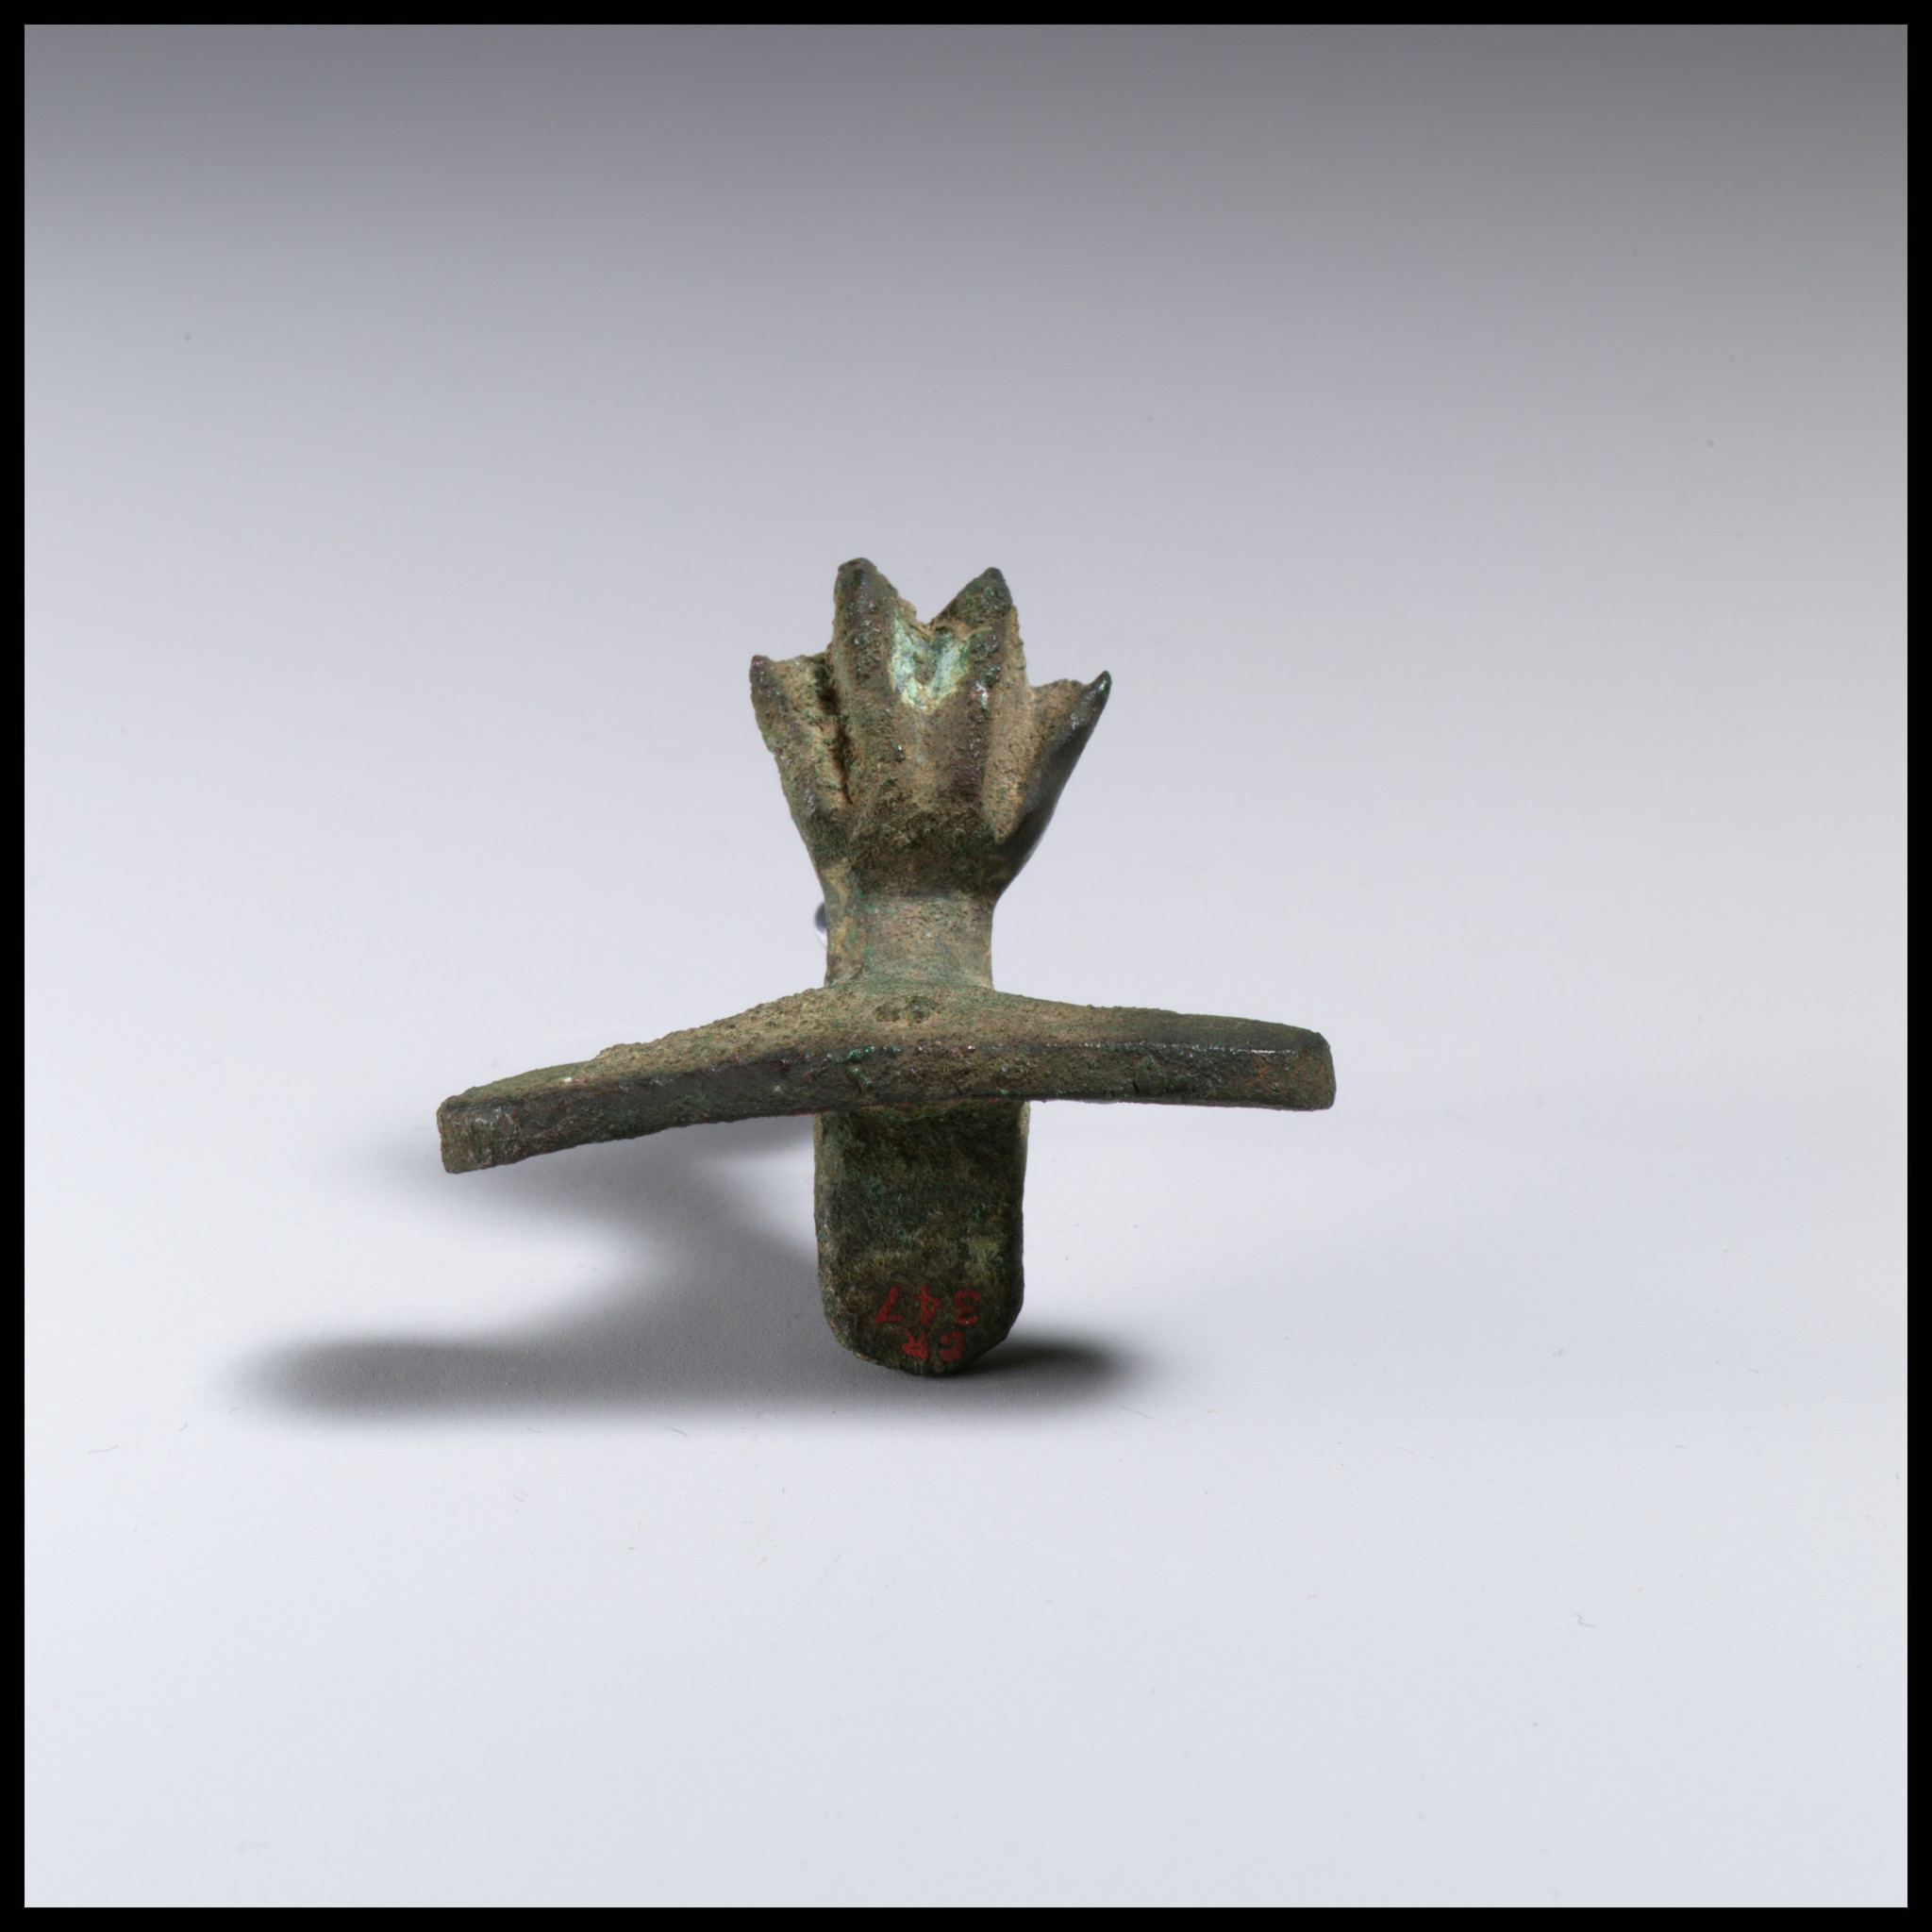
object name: cista, foot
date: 7000 BCE-330 CE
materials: bronze